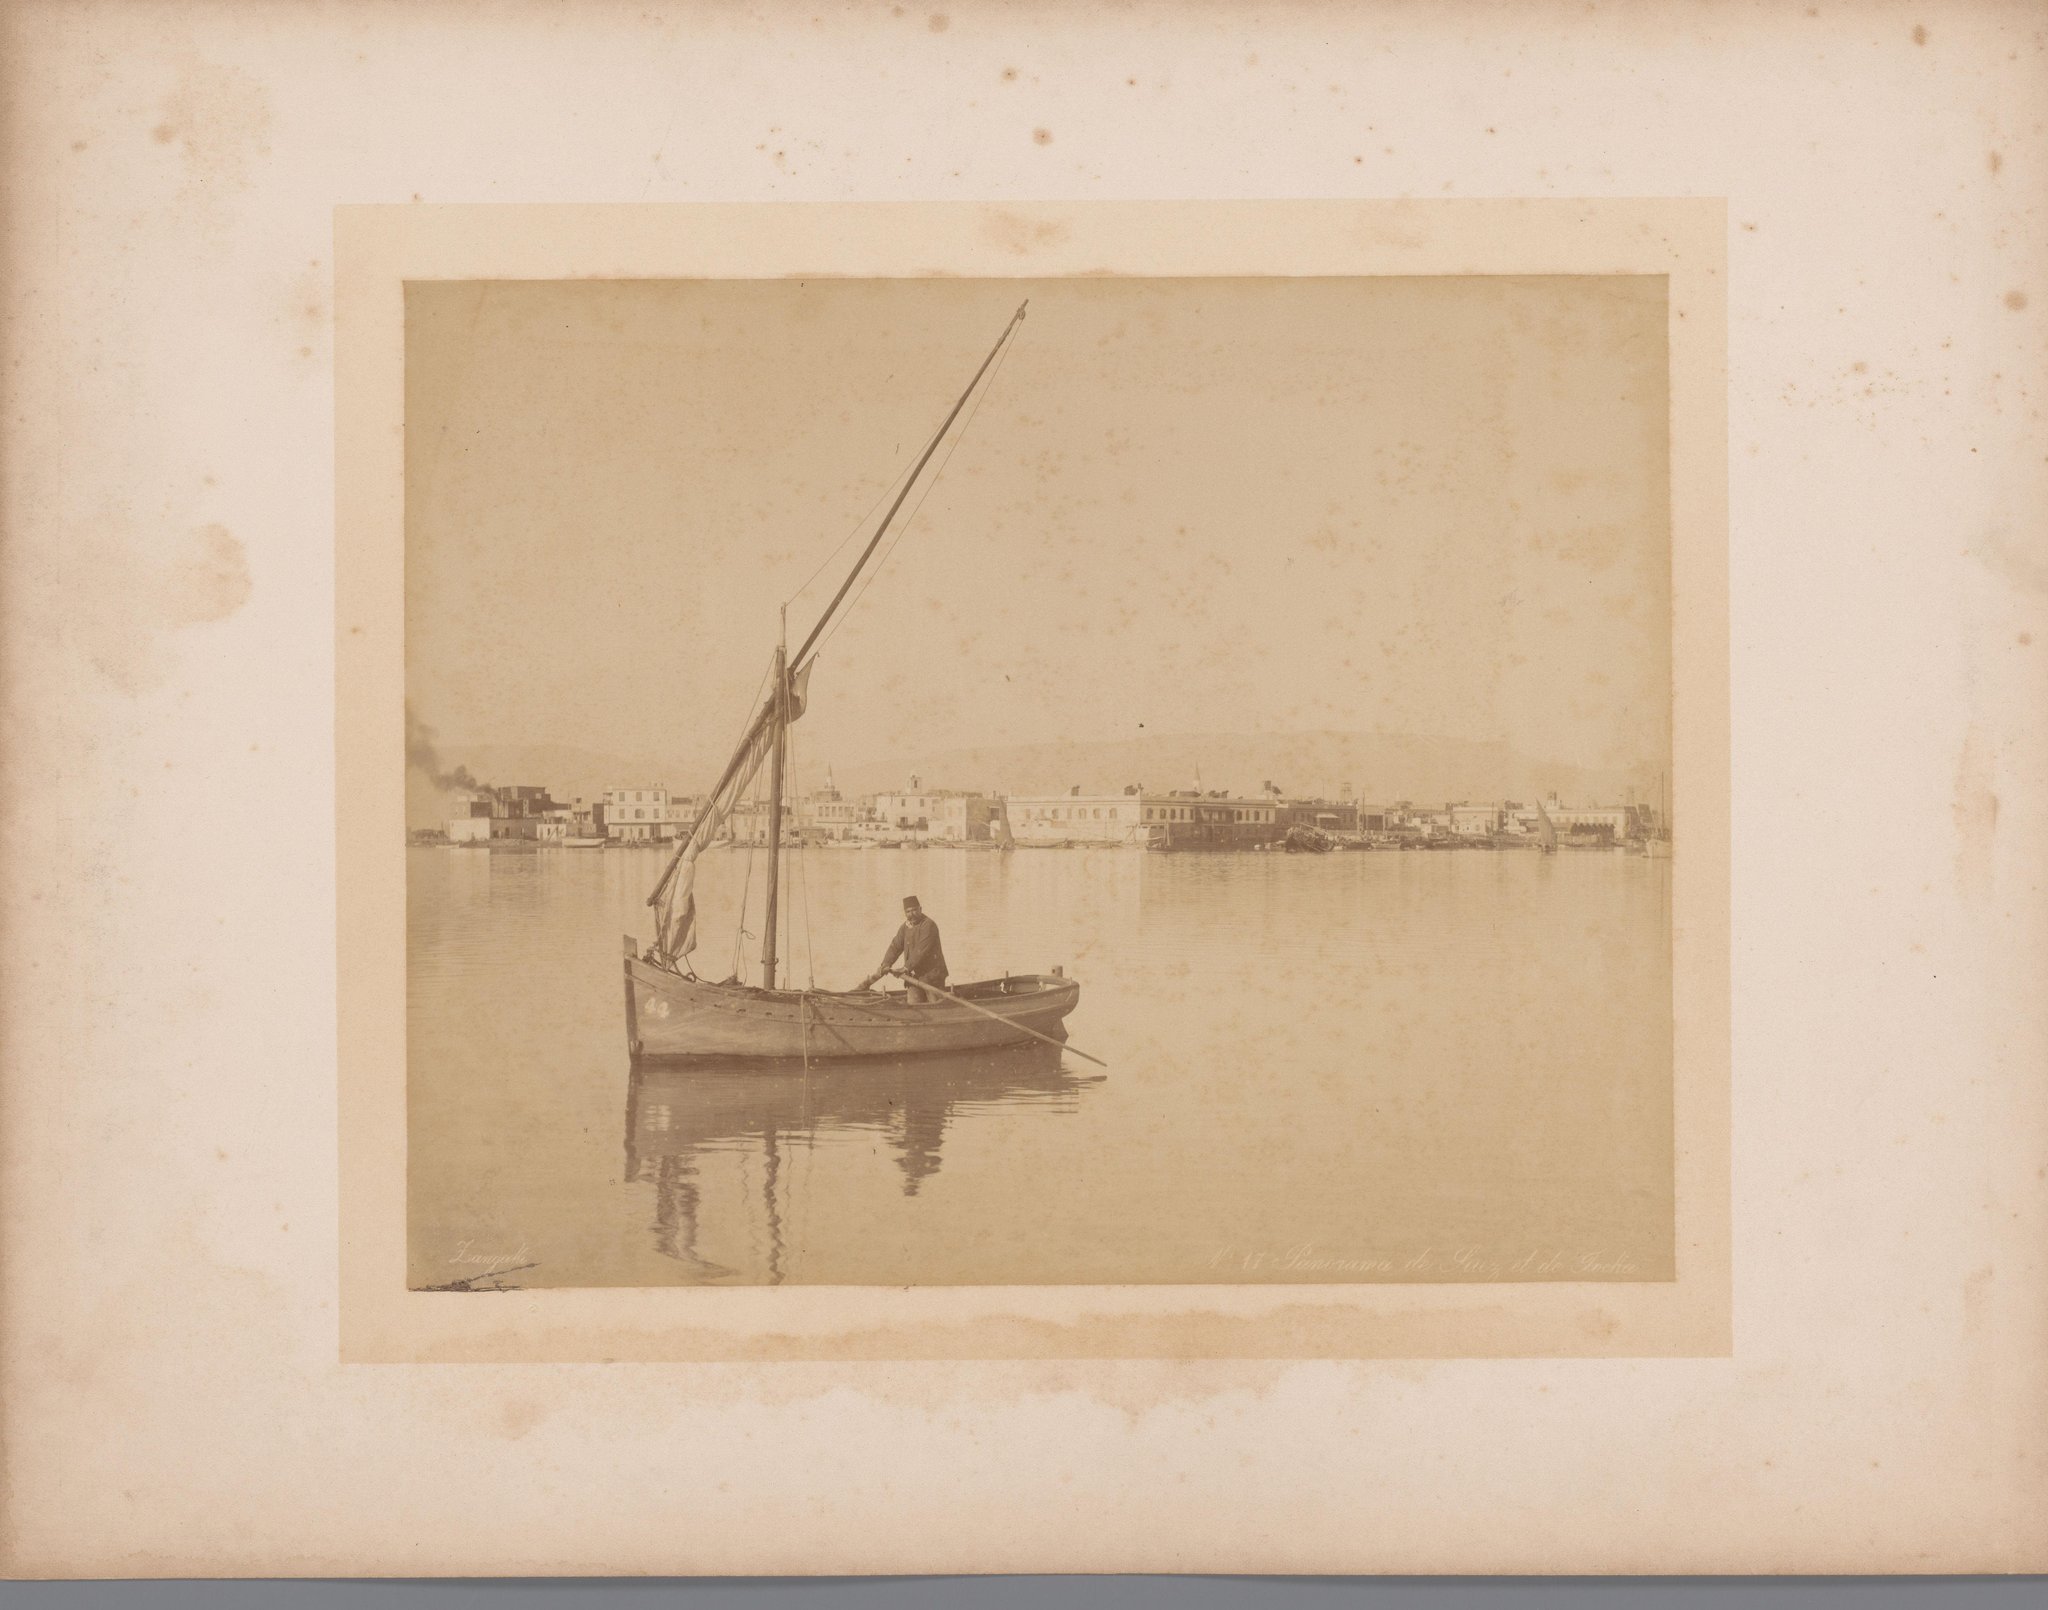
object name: photograph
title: Zeilboot op het Suezkanaal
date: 1870-1910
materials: cardboard, paper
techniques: albumen print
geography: suez canal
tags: sailing-ship, sailing-boat, canal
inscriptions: inscription: ‘foto Zangaki/ Panorama Suez’, number: ‘No 17’